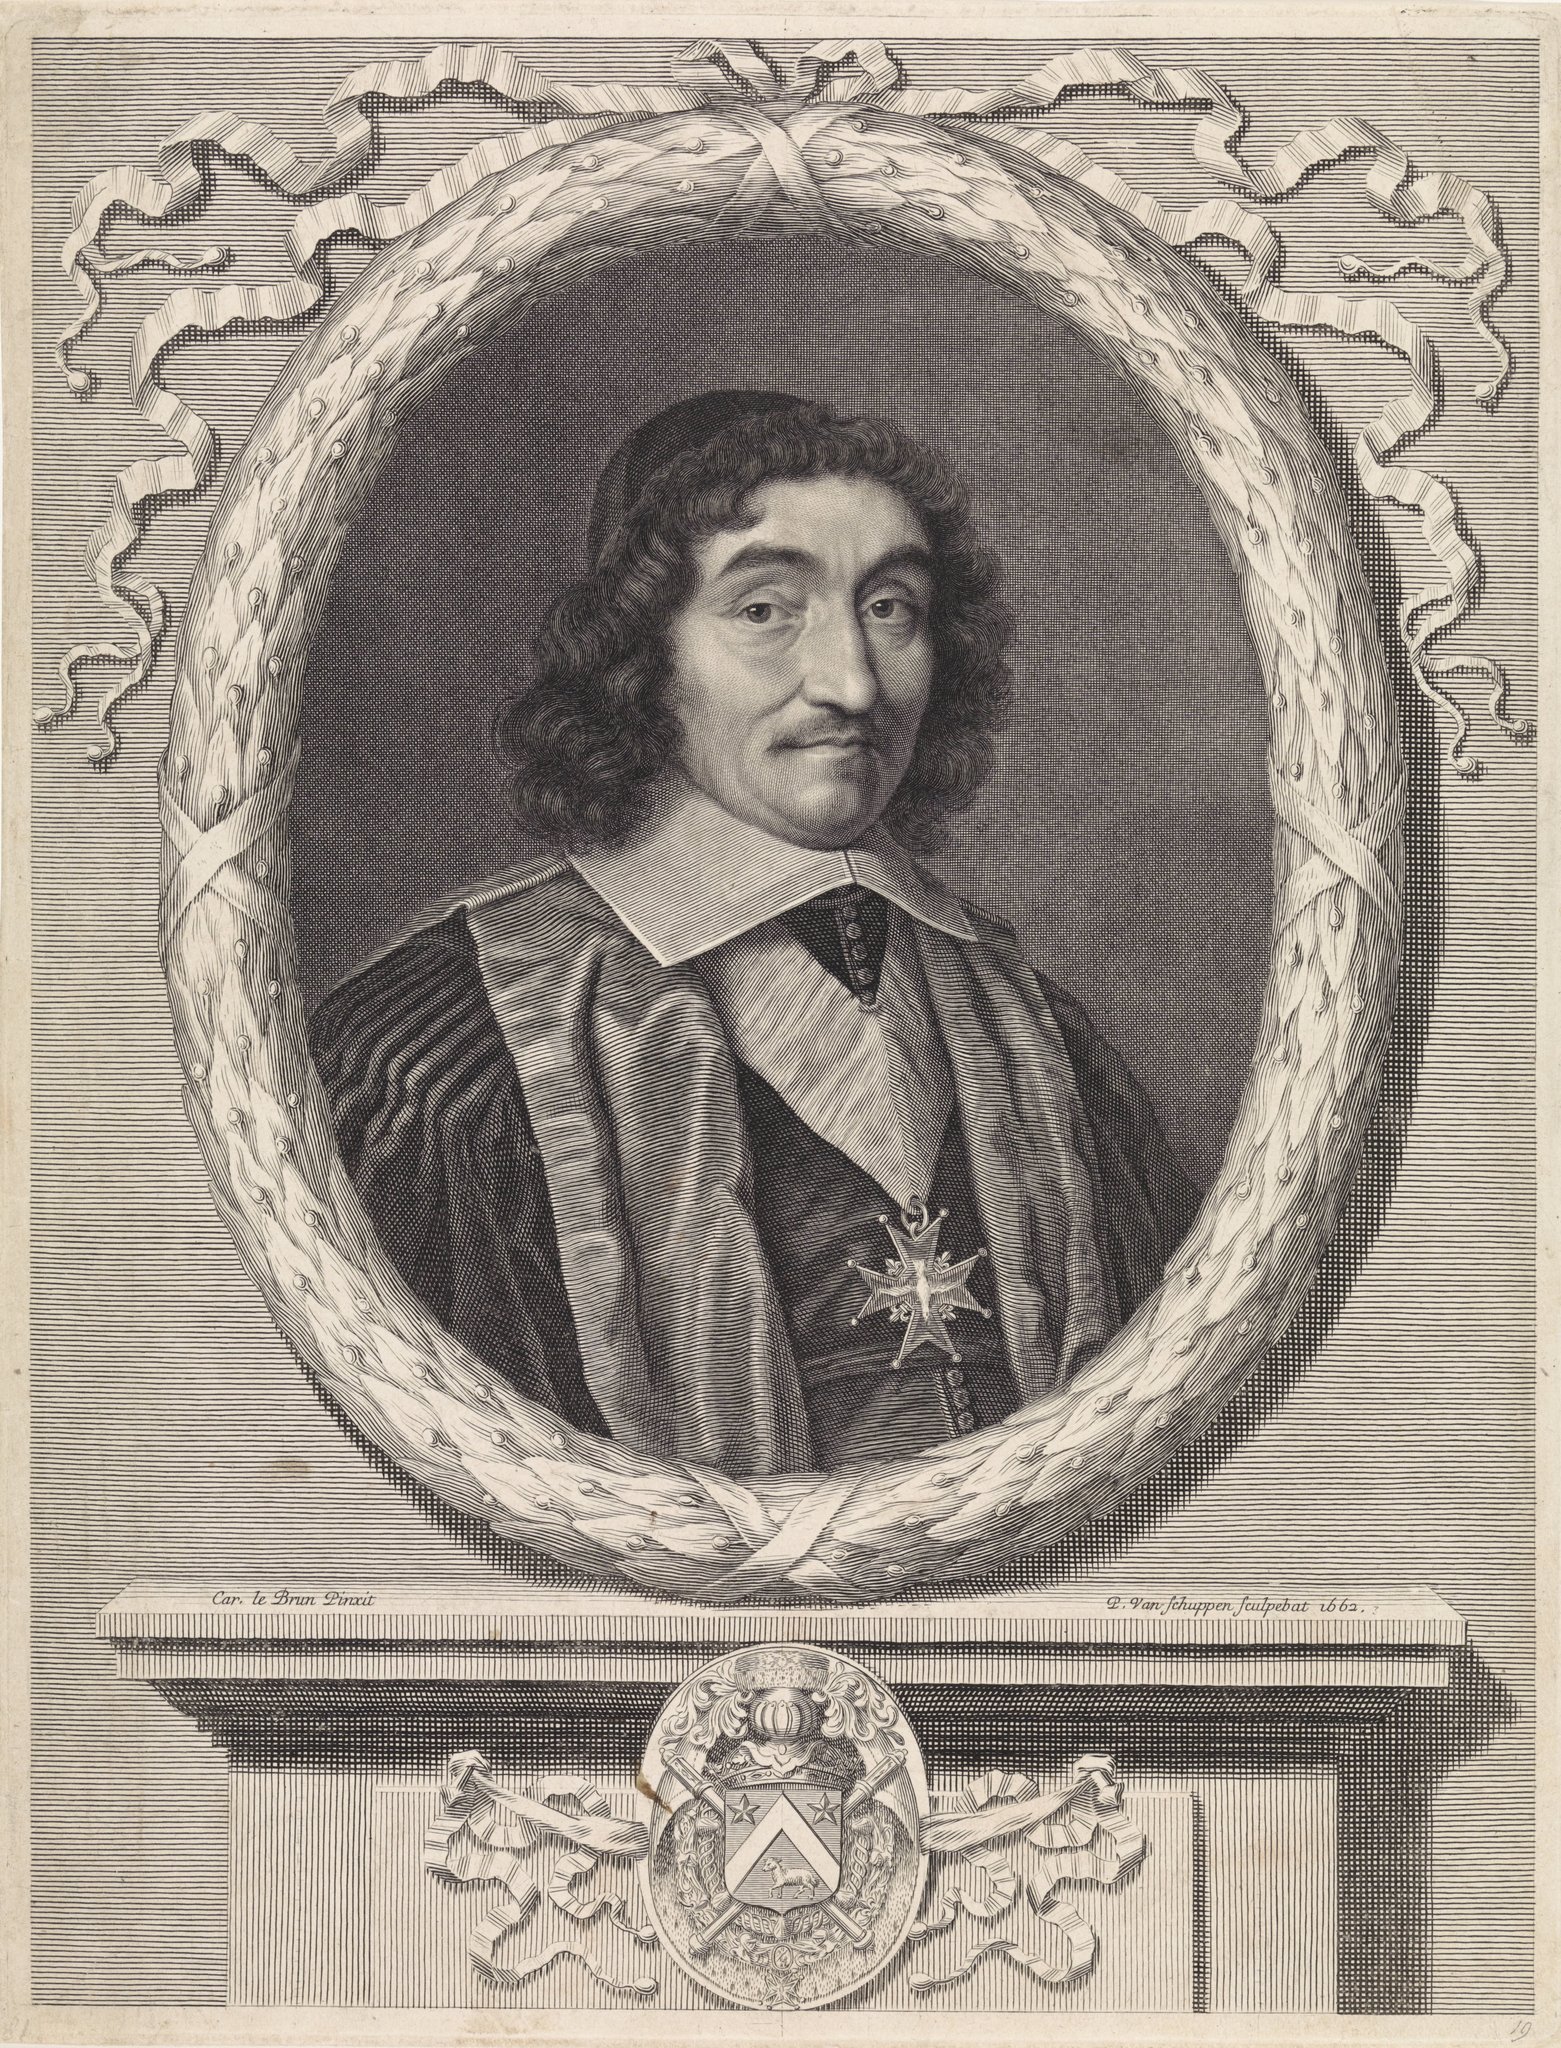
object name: print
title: Portret van de Franse kanselier Pierre Seguier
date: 1603-1662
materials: paper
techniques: engraving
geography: paris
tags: paris, pierre séguier, knighthood order of the holy spirit - insignia of a knighthood order, e.g.: badge, chain (with name of order)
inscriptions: collector's mark: Lugt 240